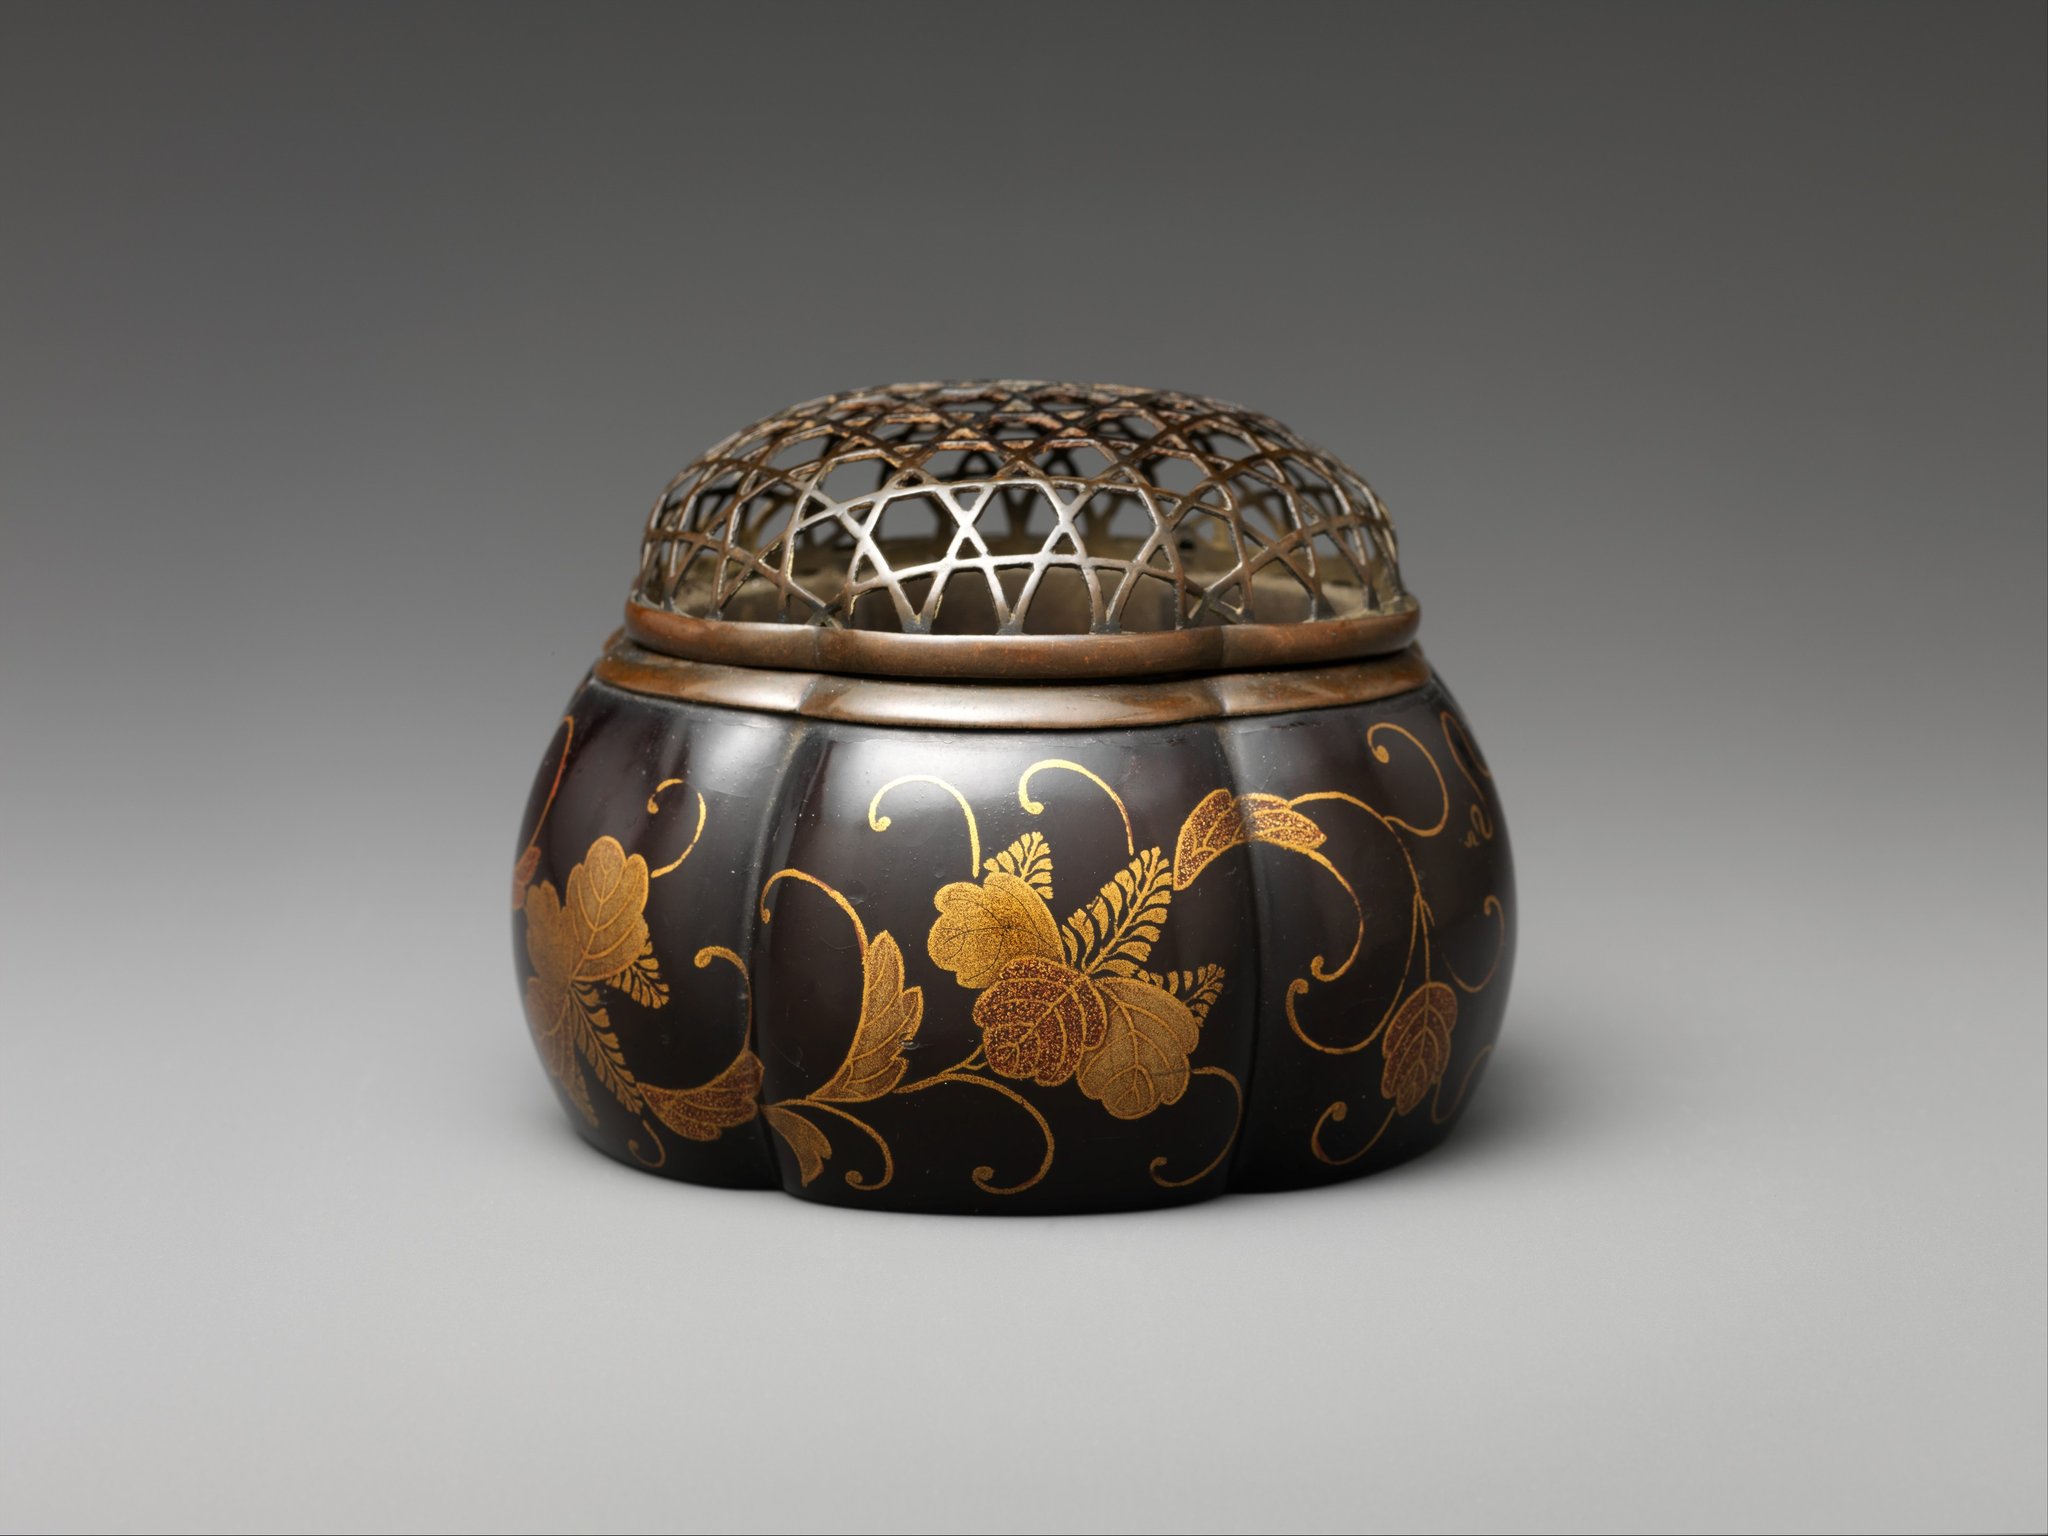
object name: incense burner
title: Melon-Shaped Incense Burner (Akoda Kōro) with Paulownia and Foliage Scroll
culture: japanese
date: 1601-1633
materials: gold, wood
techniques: hiramakie, lacquer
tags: flowers